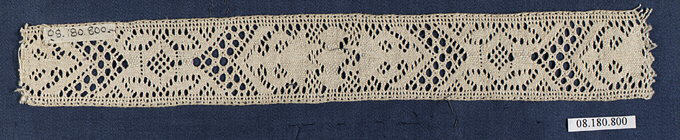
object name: insertion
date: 1801-1900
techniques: lace